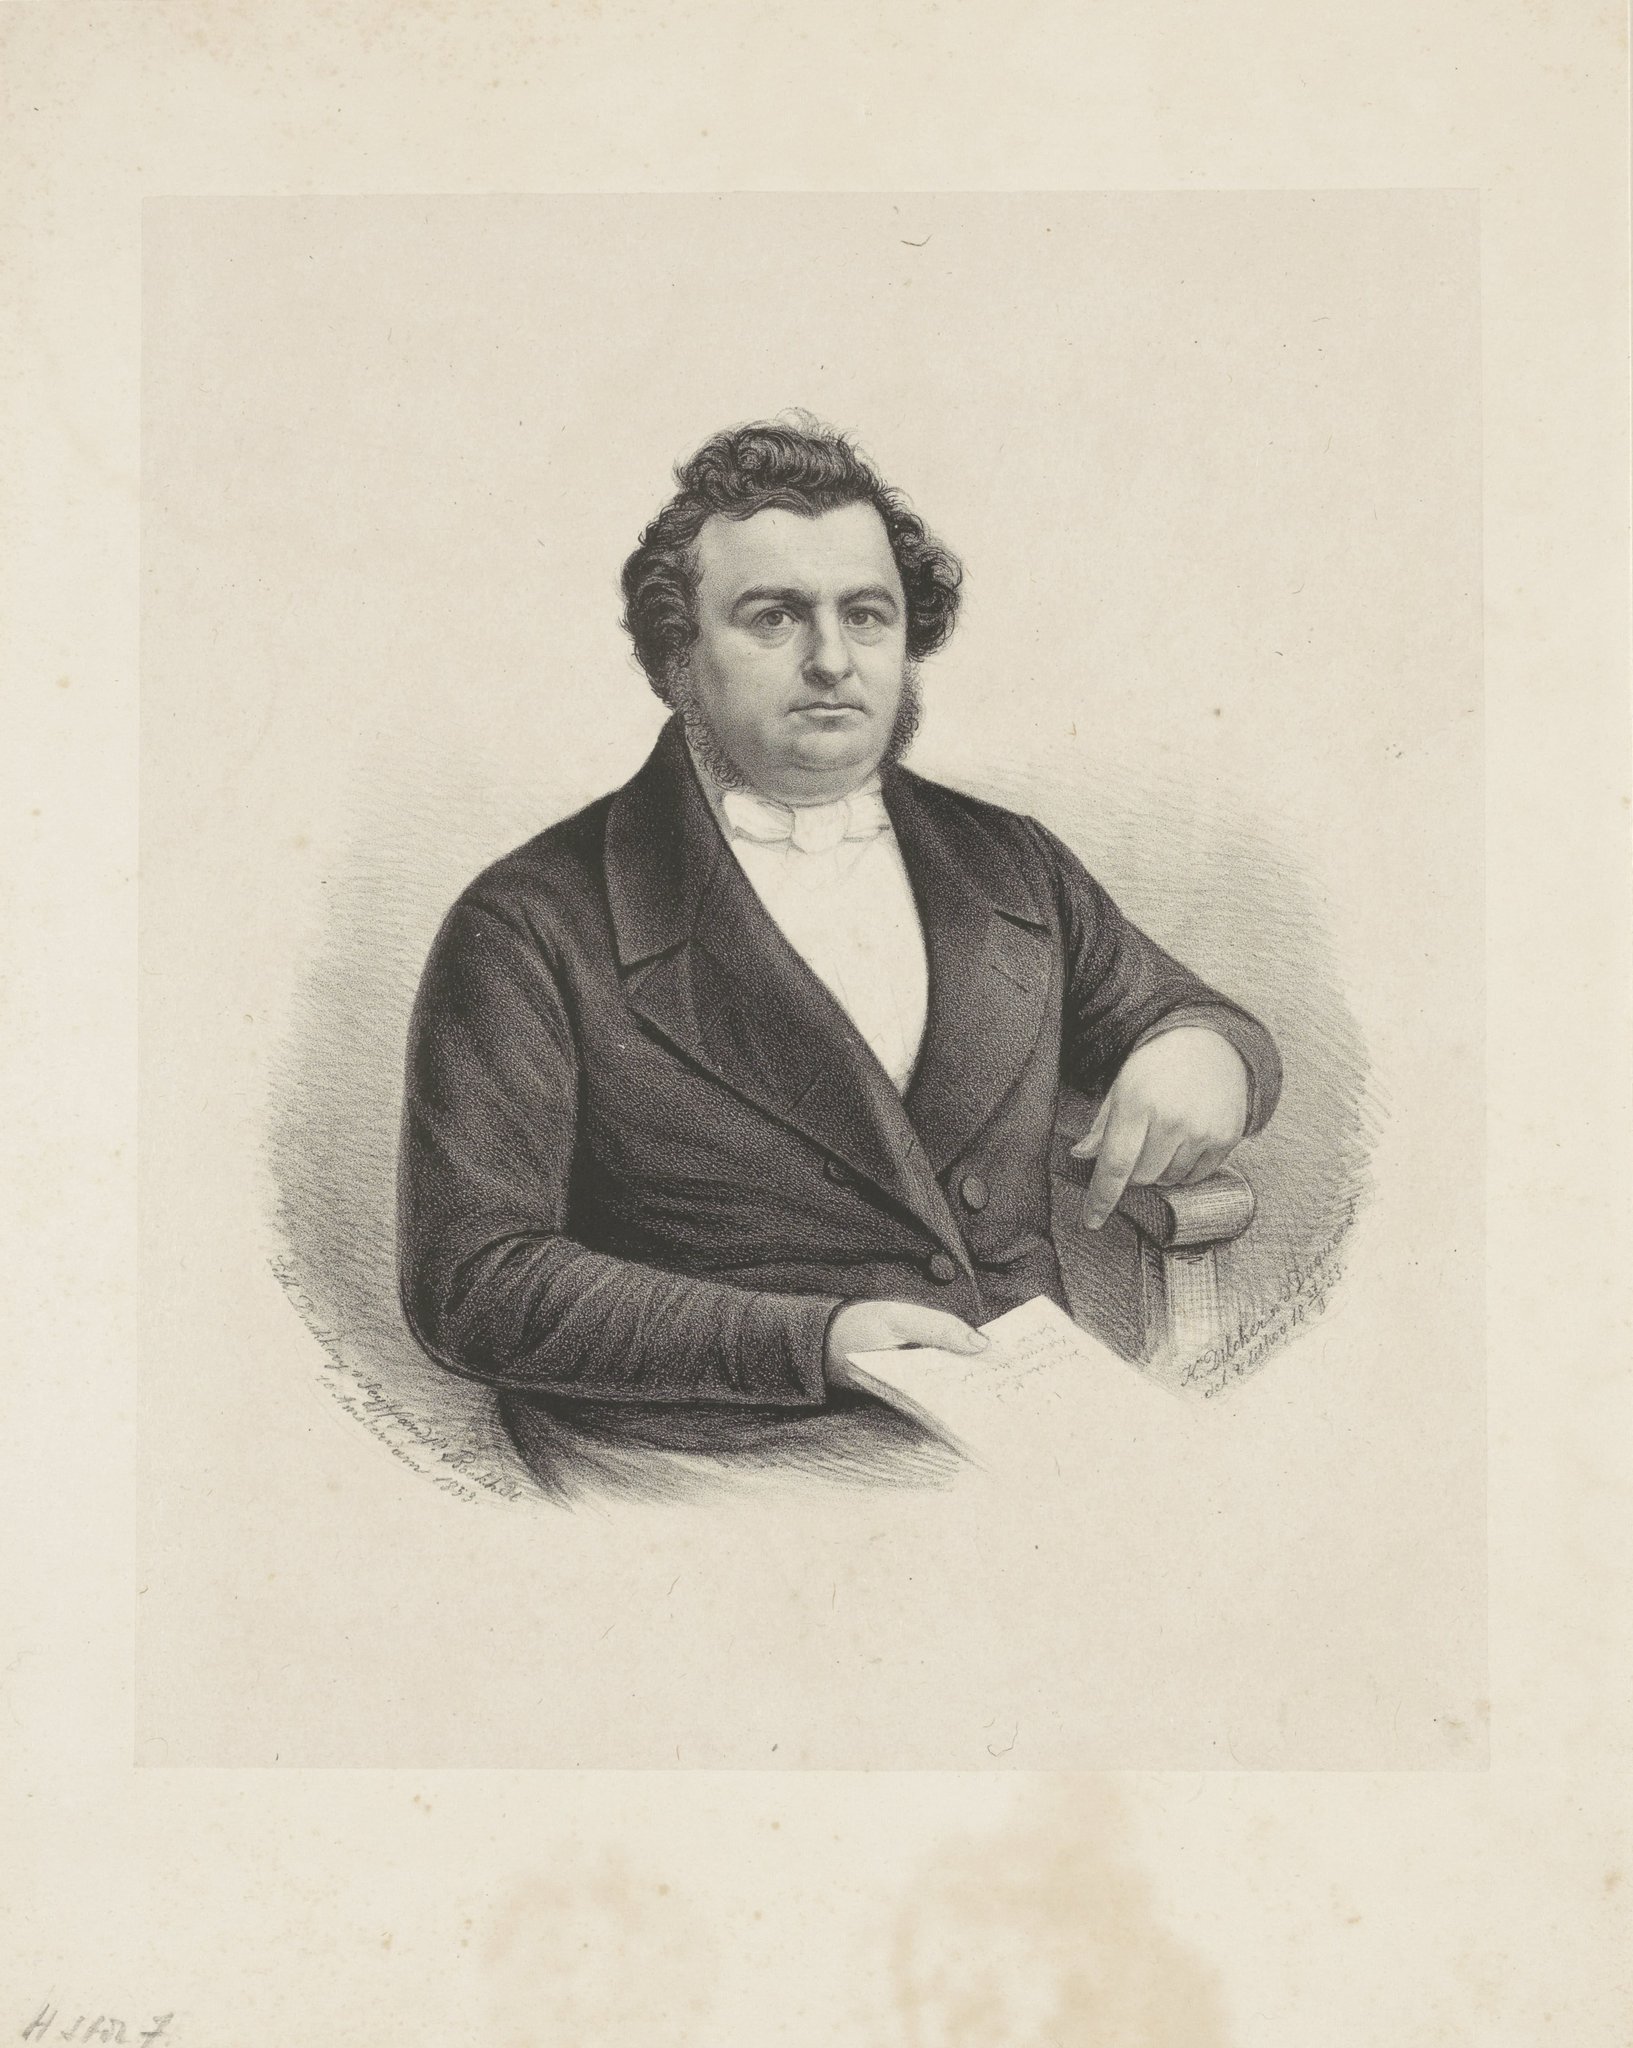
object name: print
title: Portret van een onbekende man, mogelijk Franciscus Cornelis Donders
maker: heinrich dilcher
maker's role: print maker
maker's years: 1824-1885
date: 1854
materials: paper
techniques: lithograph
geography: amsterdam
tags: historical persons (+ half-length portrait)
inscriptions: collector's mark: Lugt 2760, collector's mark: Lugt 2228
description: De geportretteerde zit op een stoel. In zijn rechterhand heeft hij enkele beschreven vellen papier.